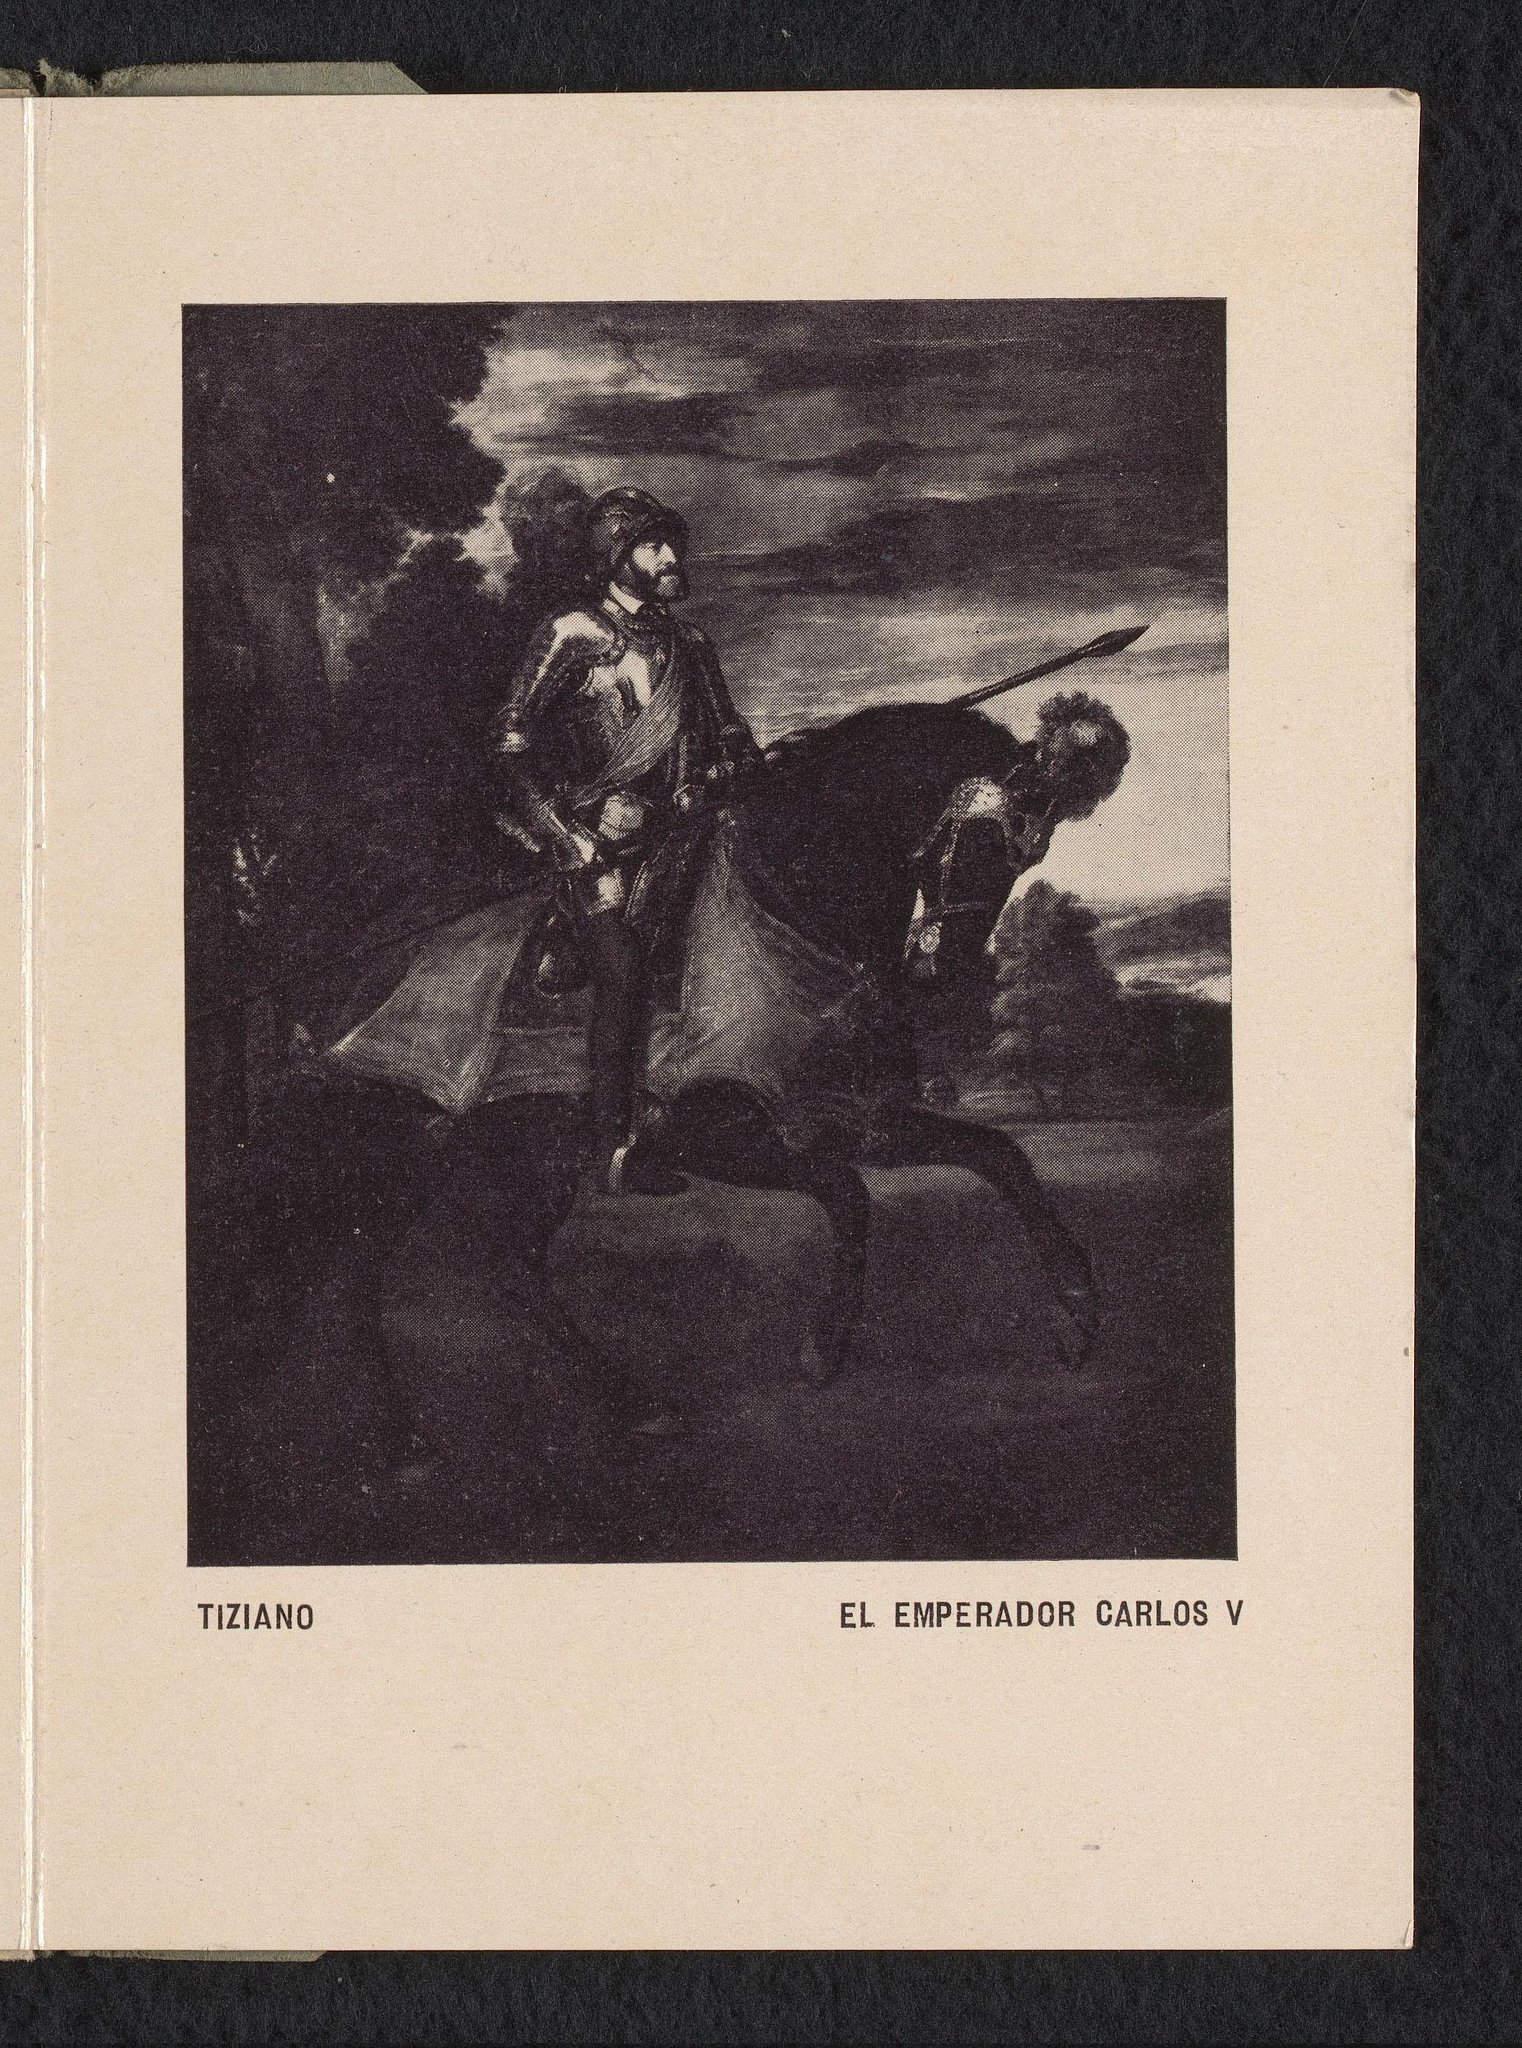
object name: ansichtkaart, prentbriefkaart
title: Tiziano. El emperador Carlos V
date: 1910-1950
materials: cardboard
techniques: autotype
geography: madrid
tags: charles v (holy roman emperor and king of spain), permanent exhibition, museum, picture, painting